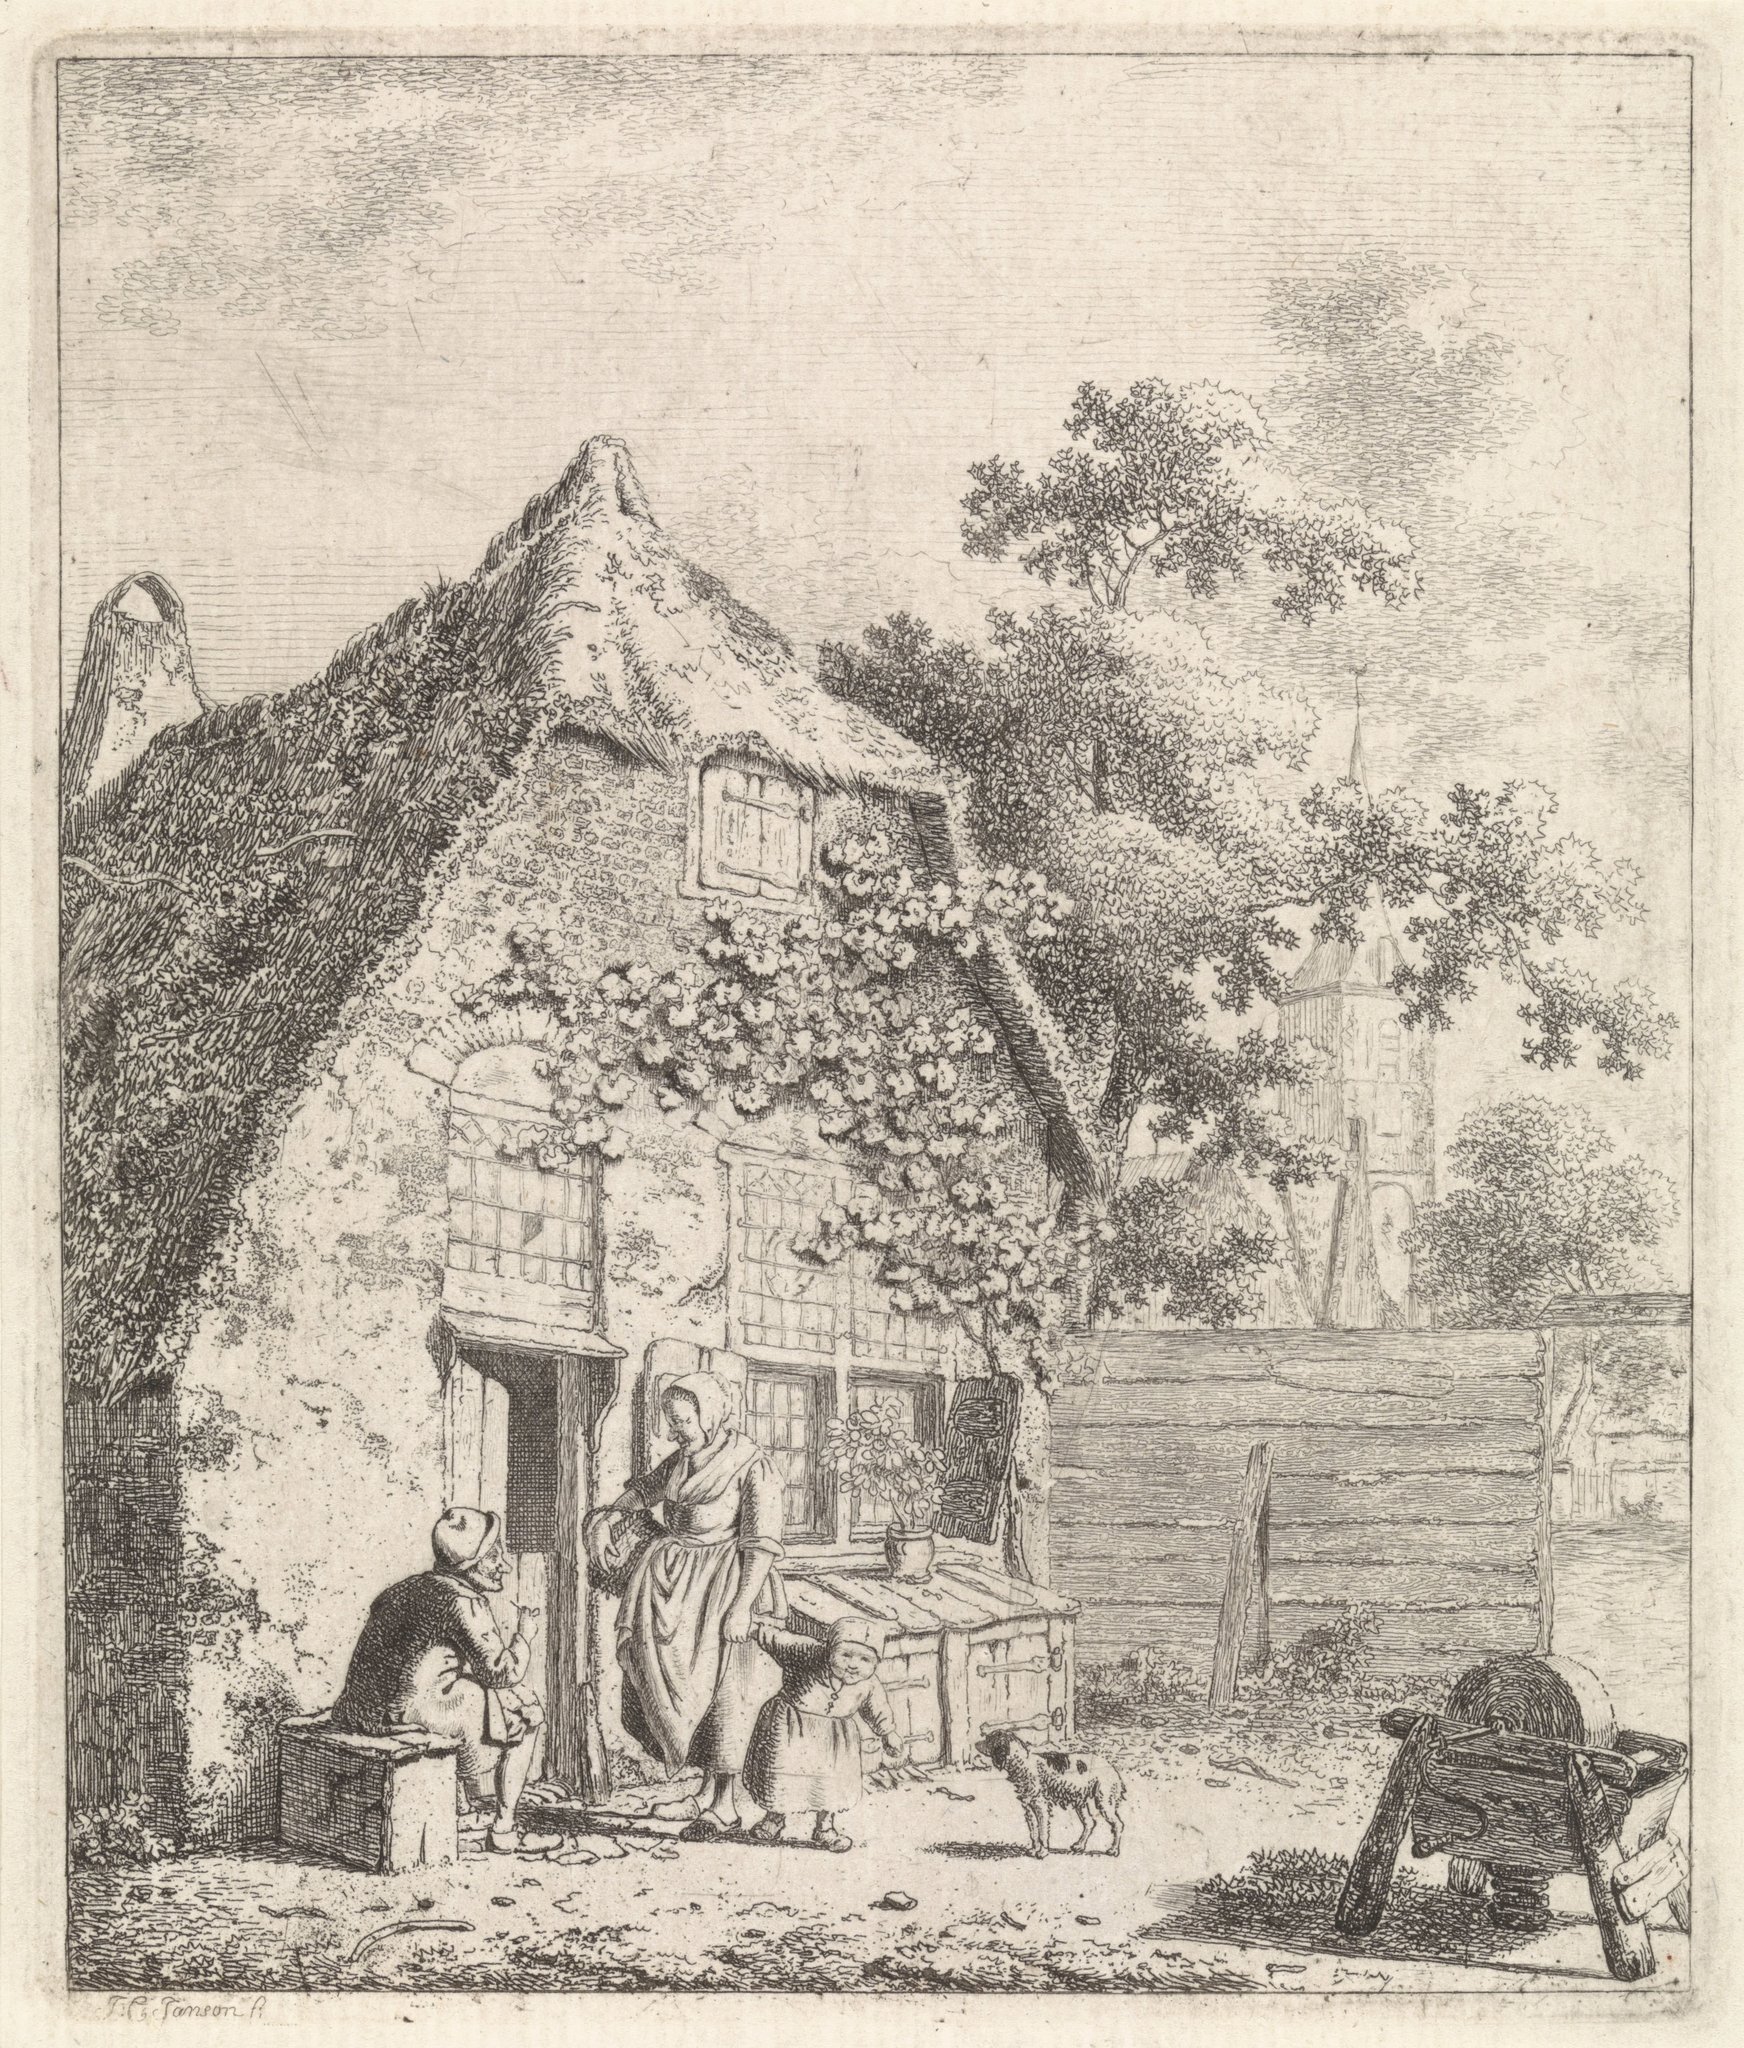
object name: print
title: Boeren in gesprek bij boerderij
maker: johannes christiaan janson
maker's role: draughtsman, painter, print maker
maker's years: 1763-1823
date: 1778-1823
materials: paper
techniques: etching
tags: mother and baby or young child, farm (building)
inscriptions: collector's mark: Lugt 2228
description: Een rokende boer, zittend voor een boerderij, in gesprek met een boerin. De boerin heeft een mand aan haar arm en een kind bij de hand, naast hen staat een hond. Op de achtergrond een kerktoren. Mét de lucht.